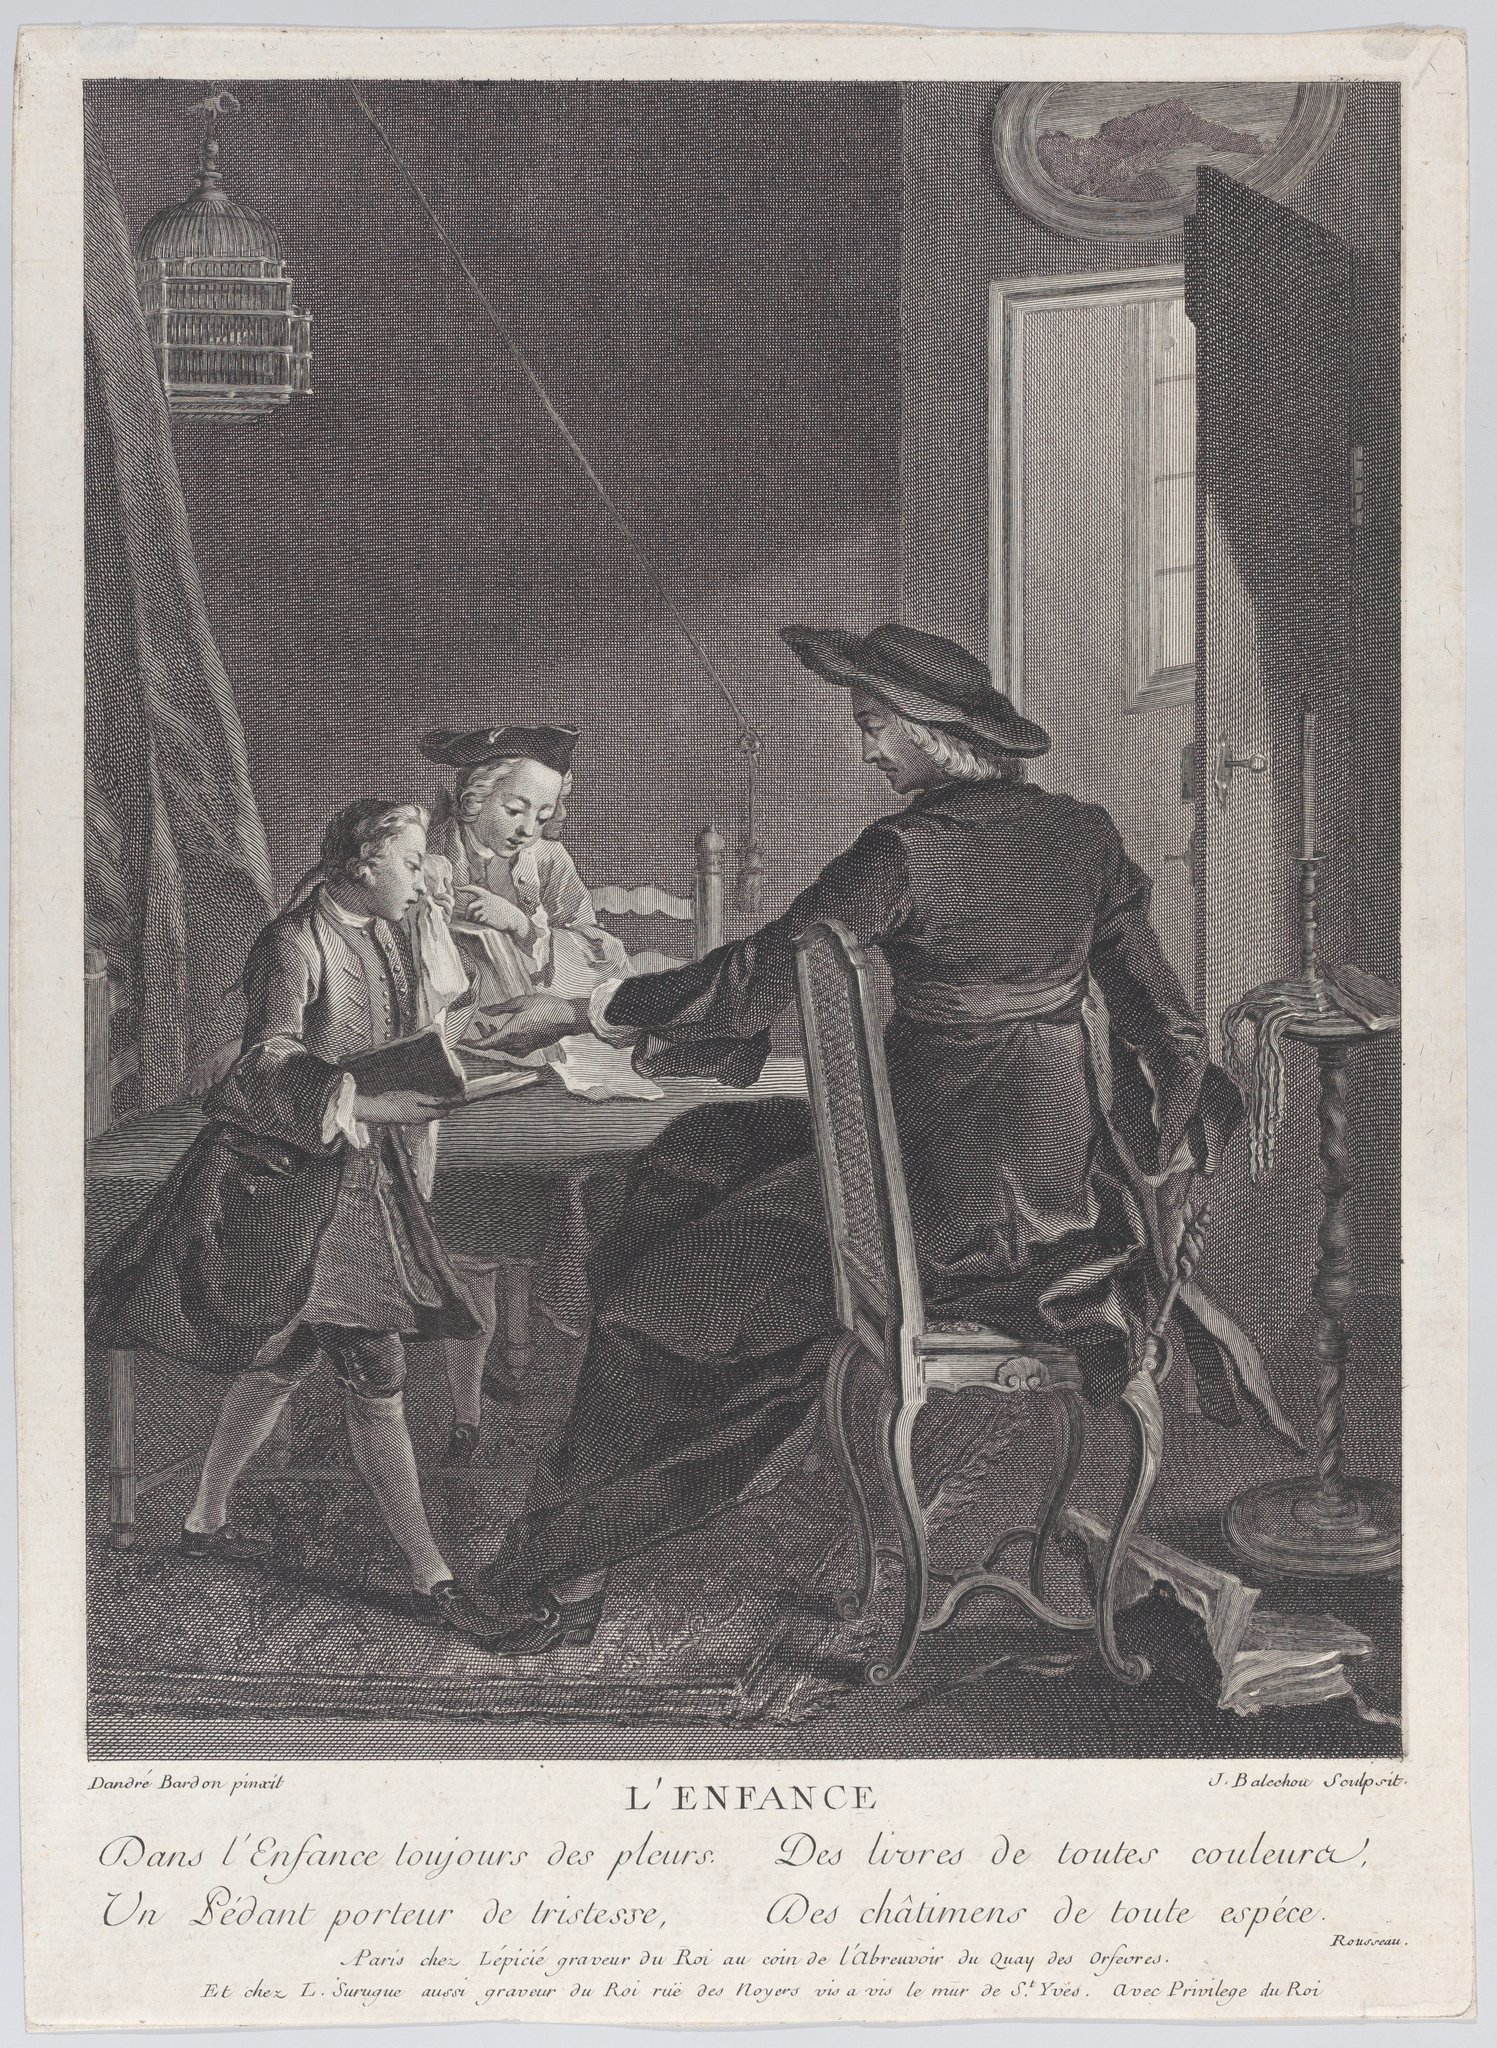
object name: print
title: L'Enfance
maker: jean-joseph baléchou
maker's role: artist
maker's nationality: french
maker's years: 1716-1764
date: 1744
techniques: engraving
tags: boys,men,reading